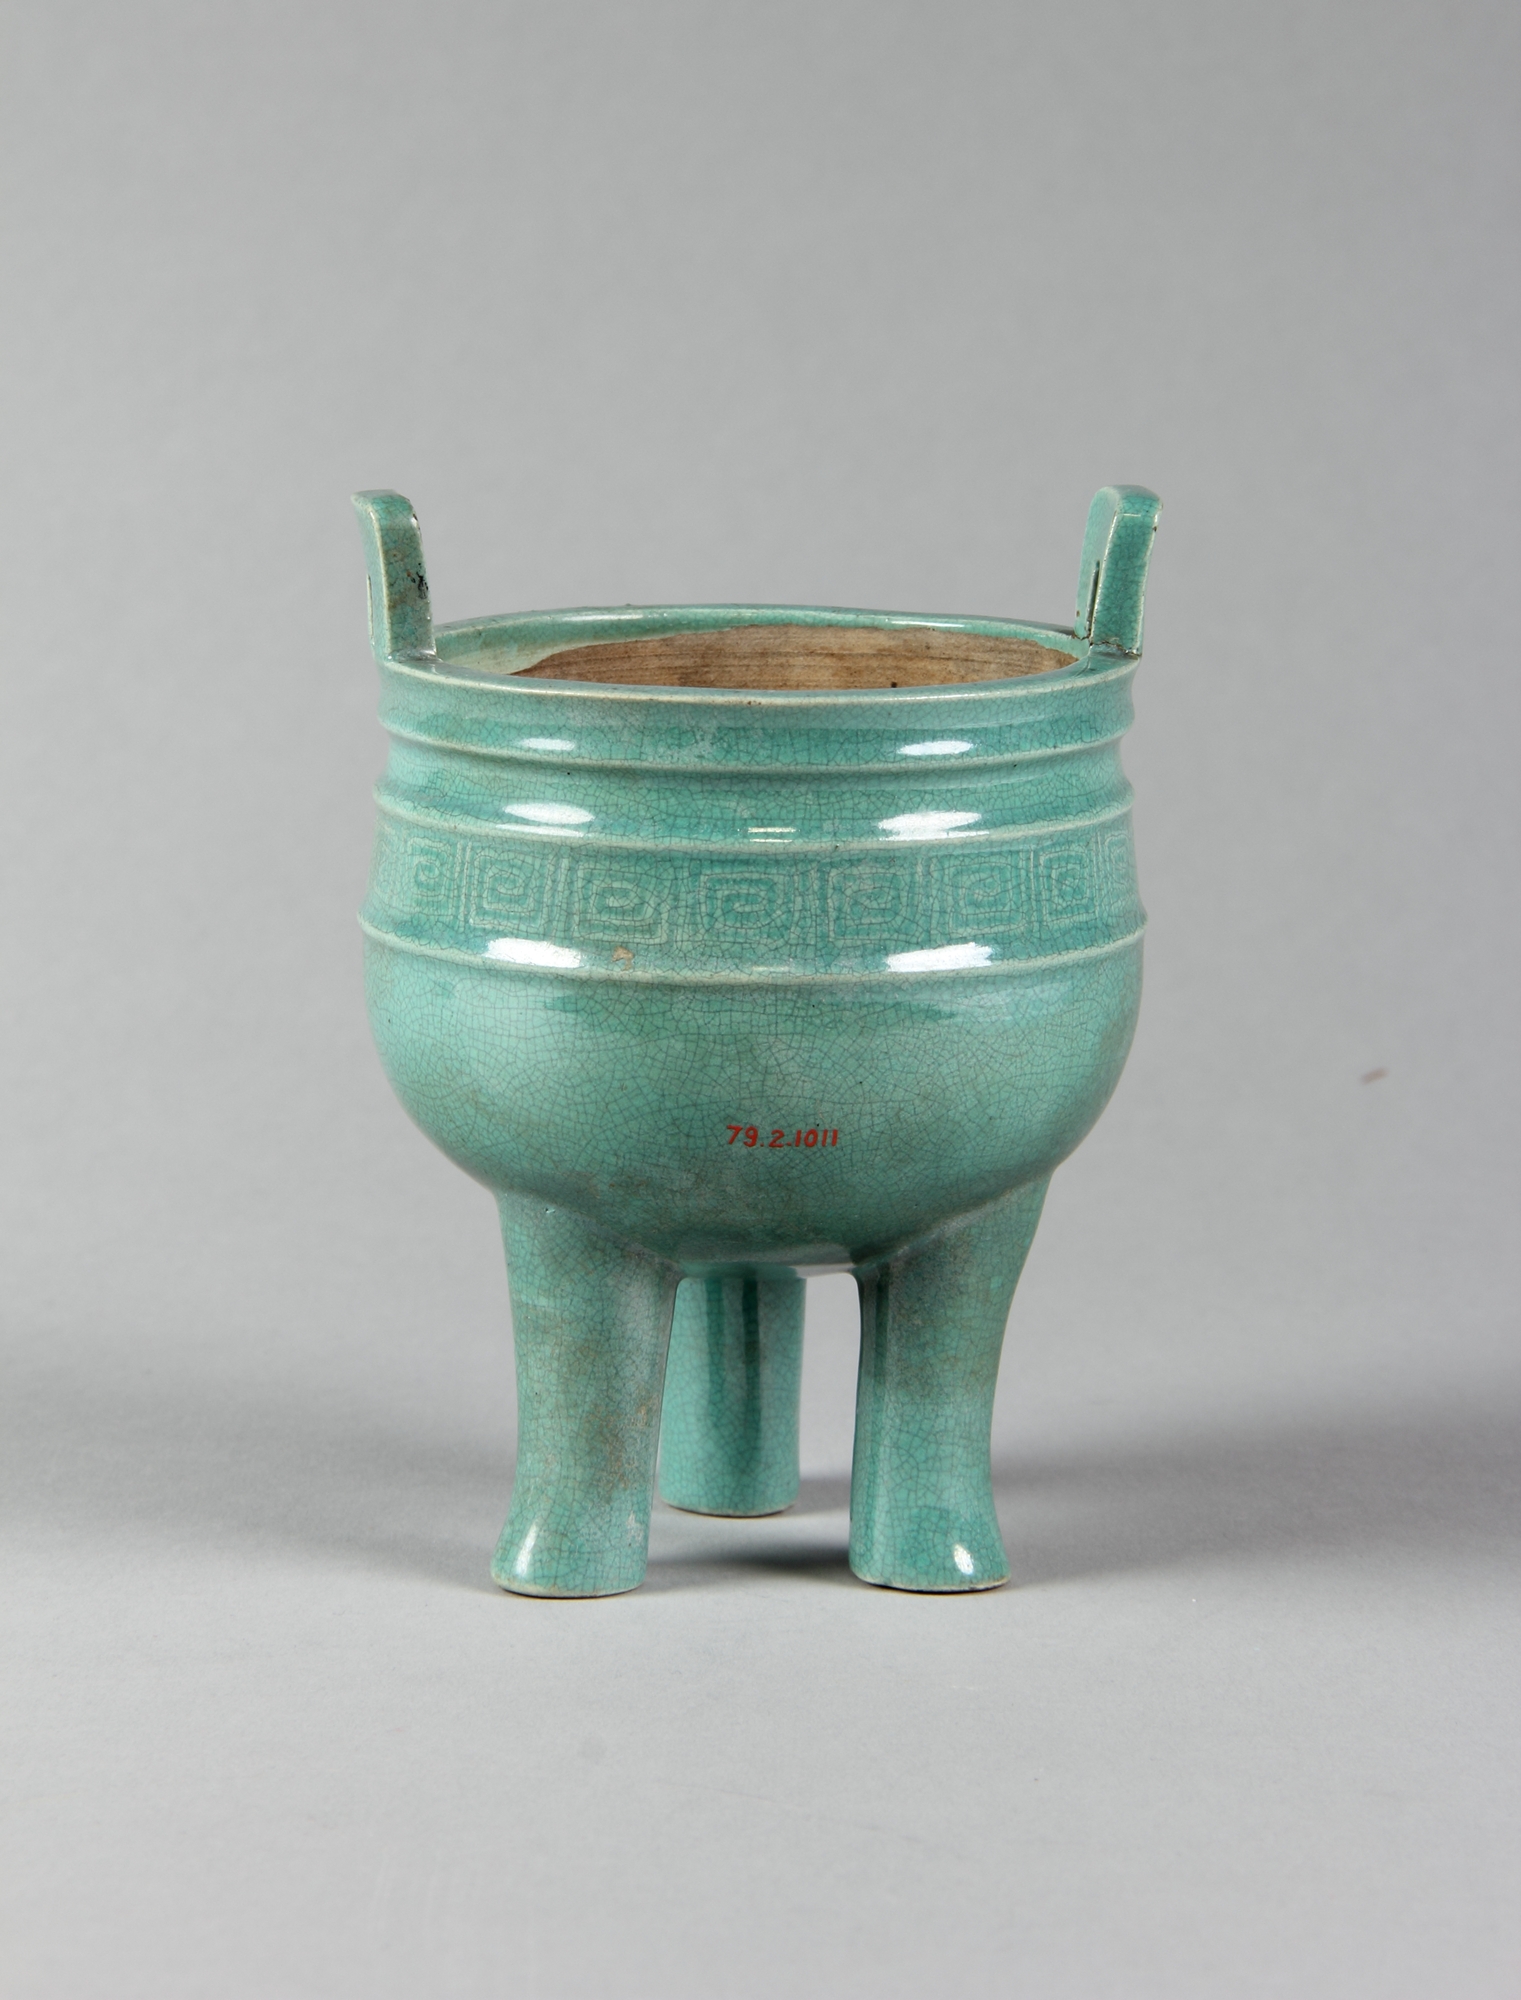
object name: incense burner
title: Tripod incense burner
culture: chinese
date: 1801-1850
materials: glaze, porcelain